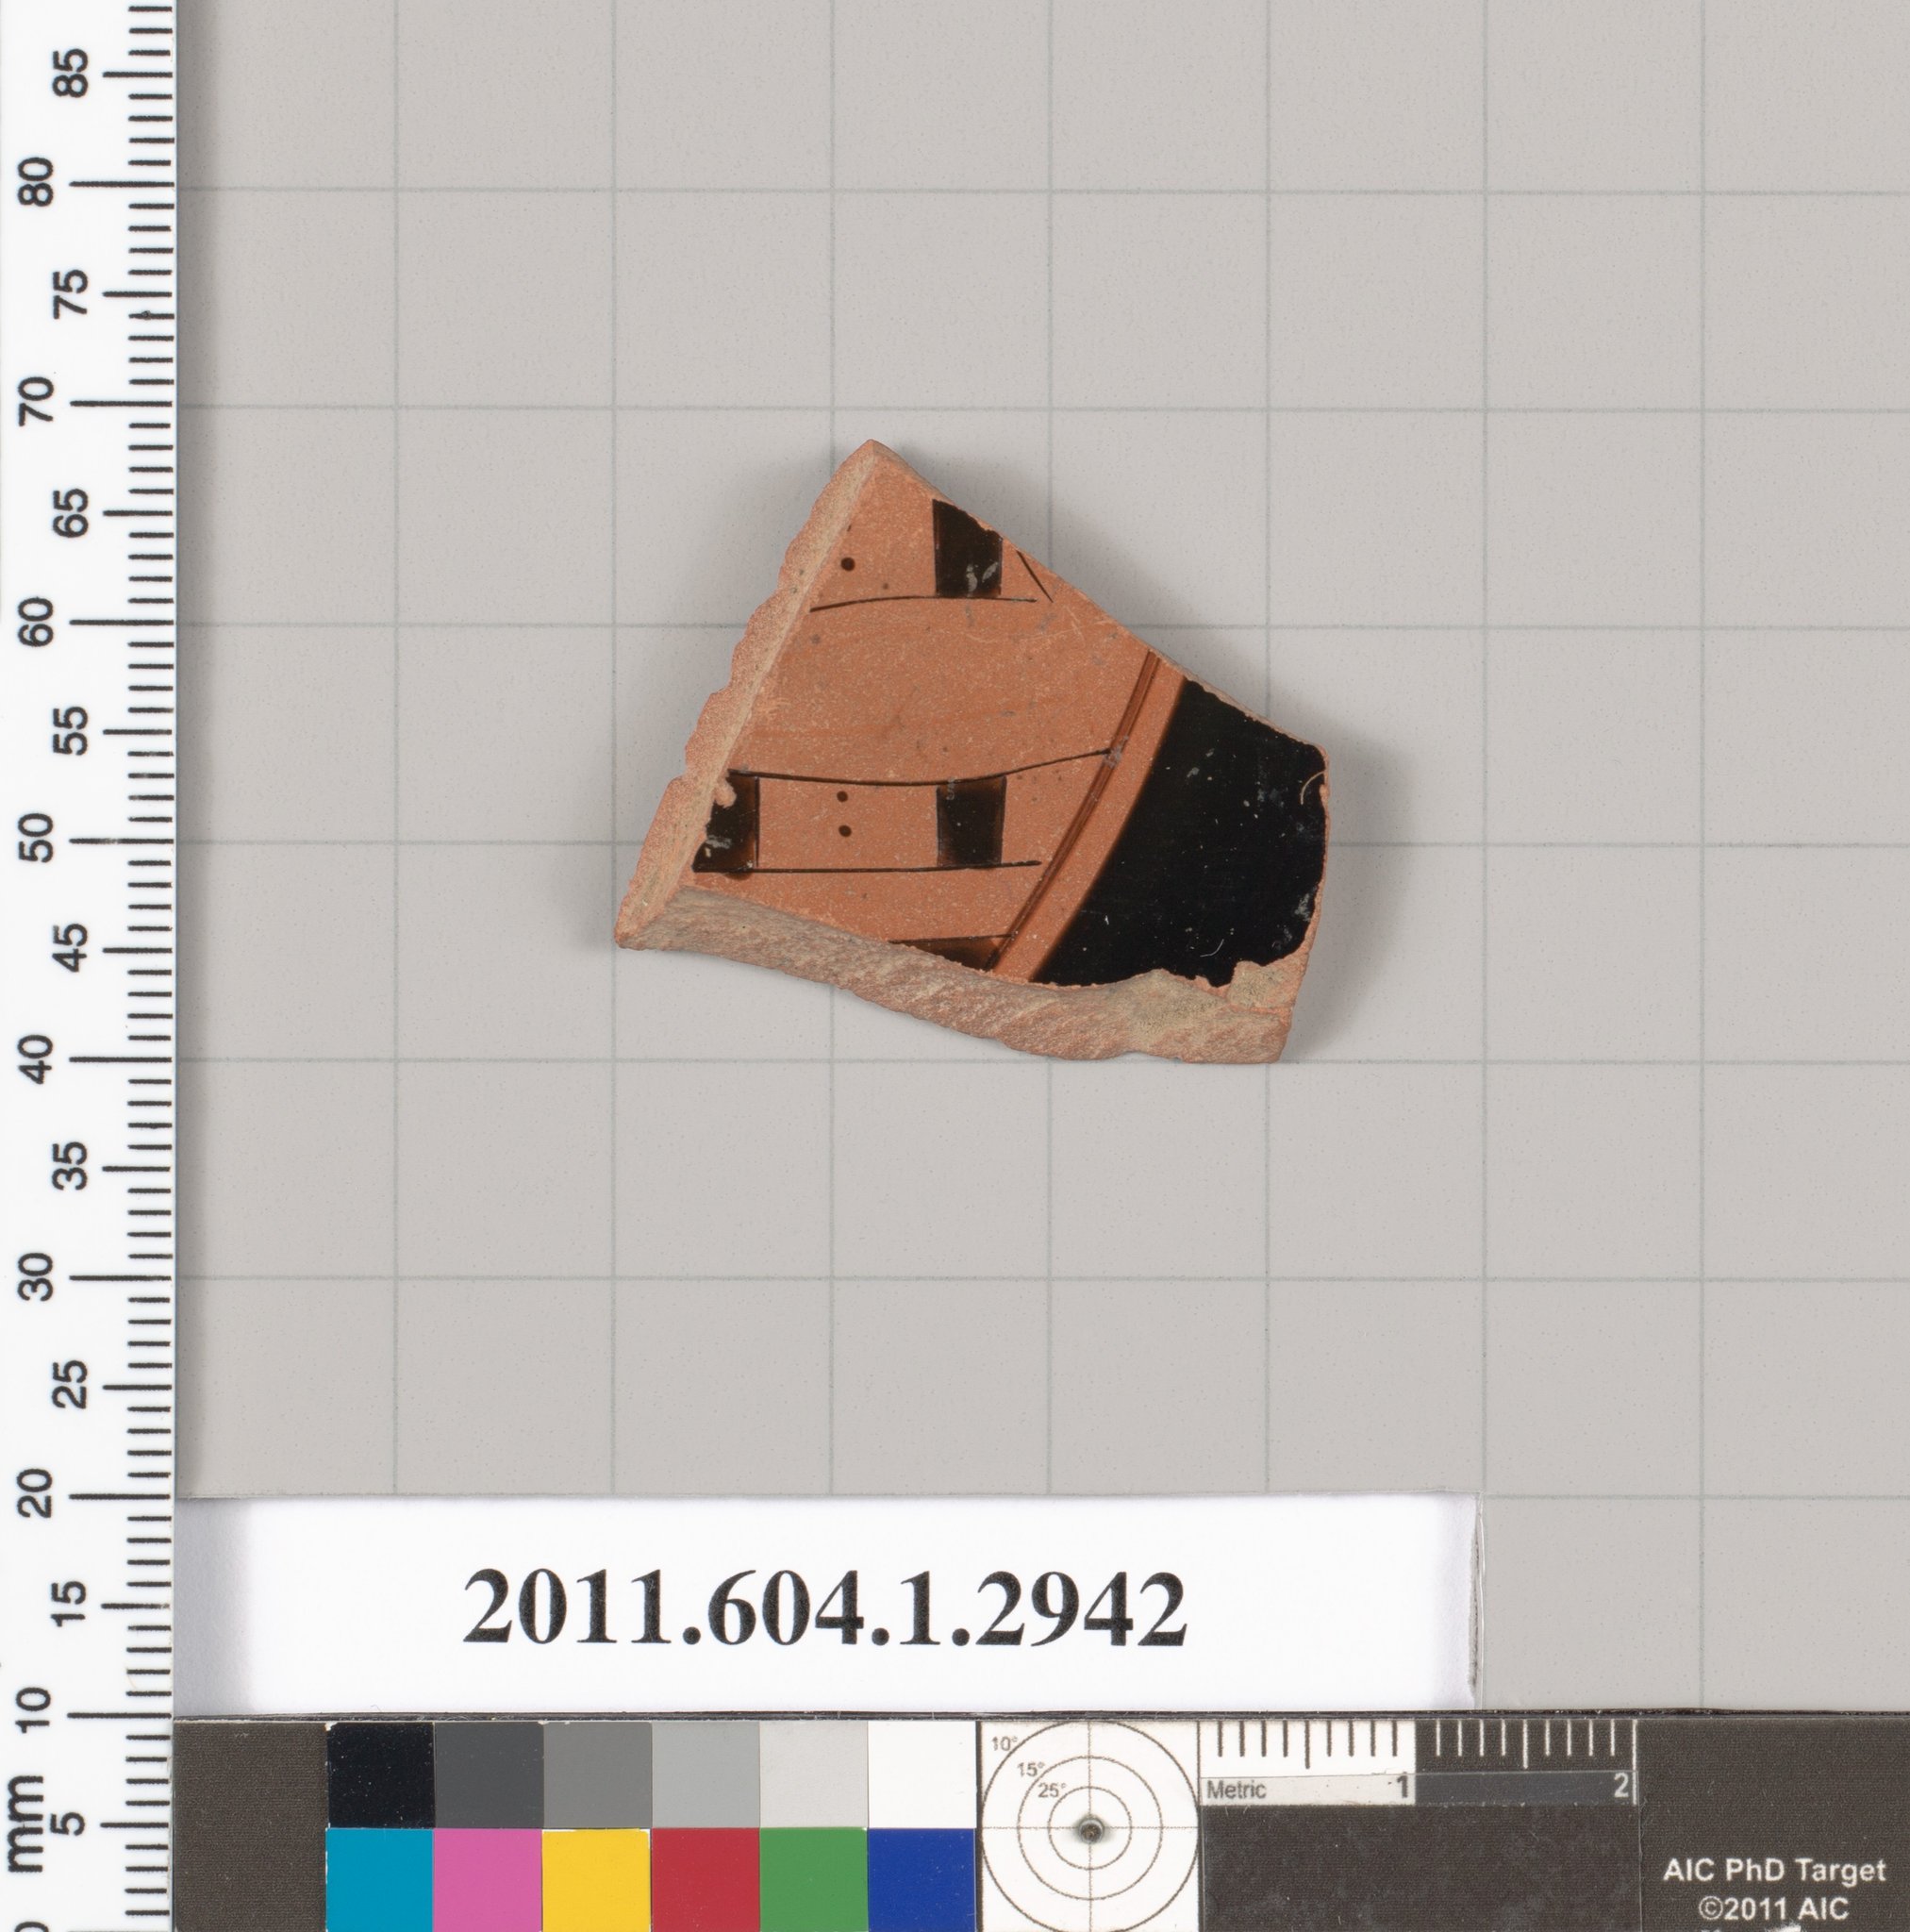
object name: kylix fragment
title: Terracotta fragment of a kylix (drinking cup)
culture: greek, attic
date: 490-480 BCE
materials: terracotta